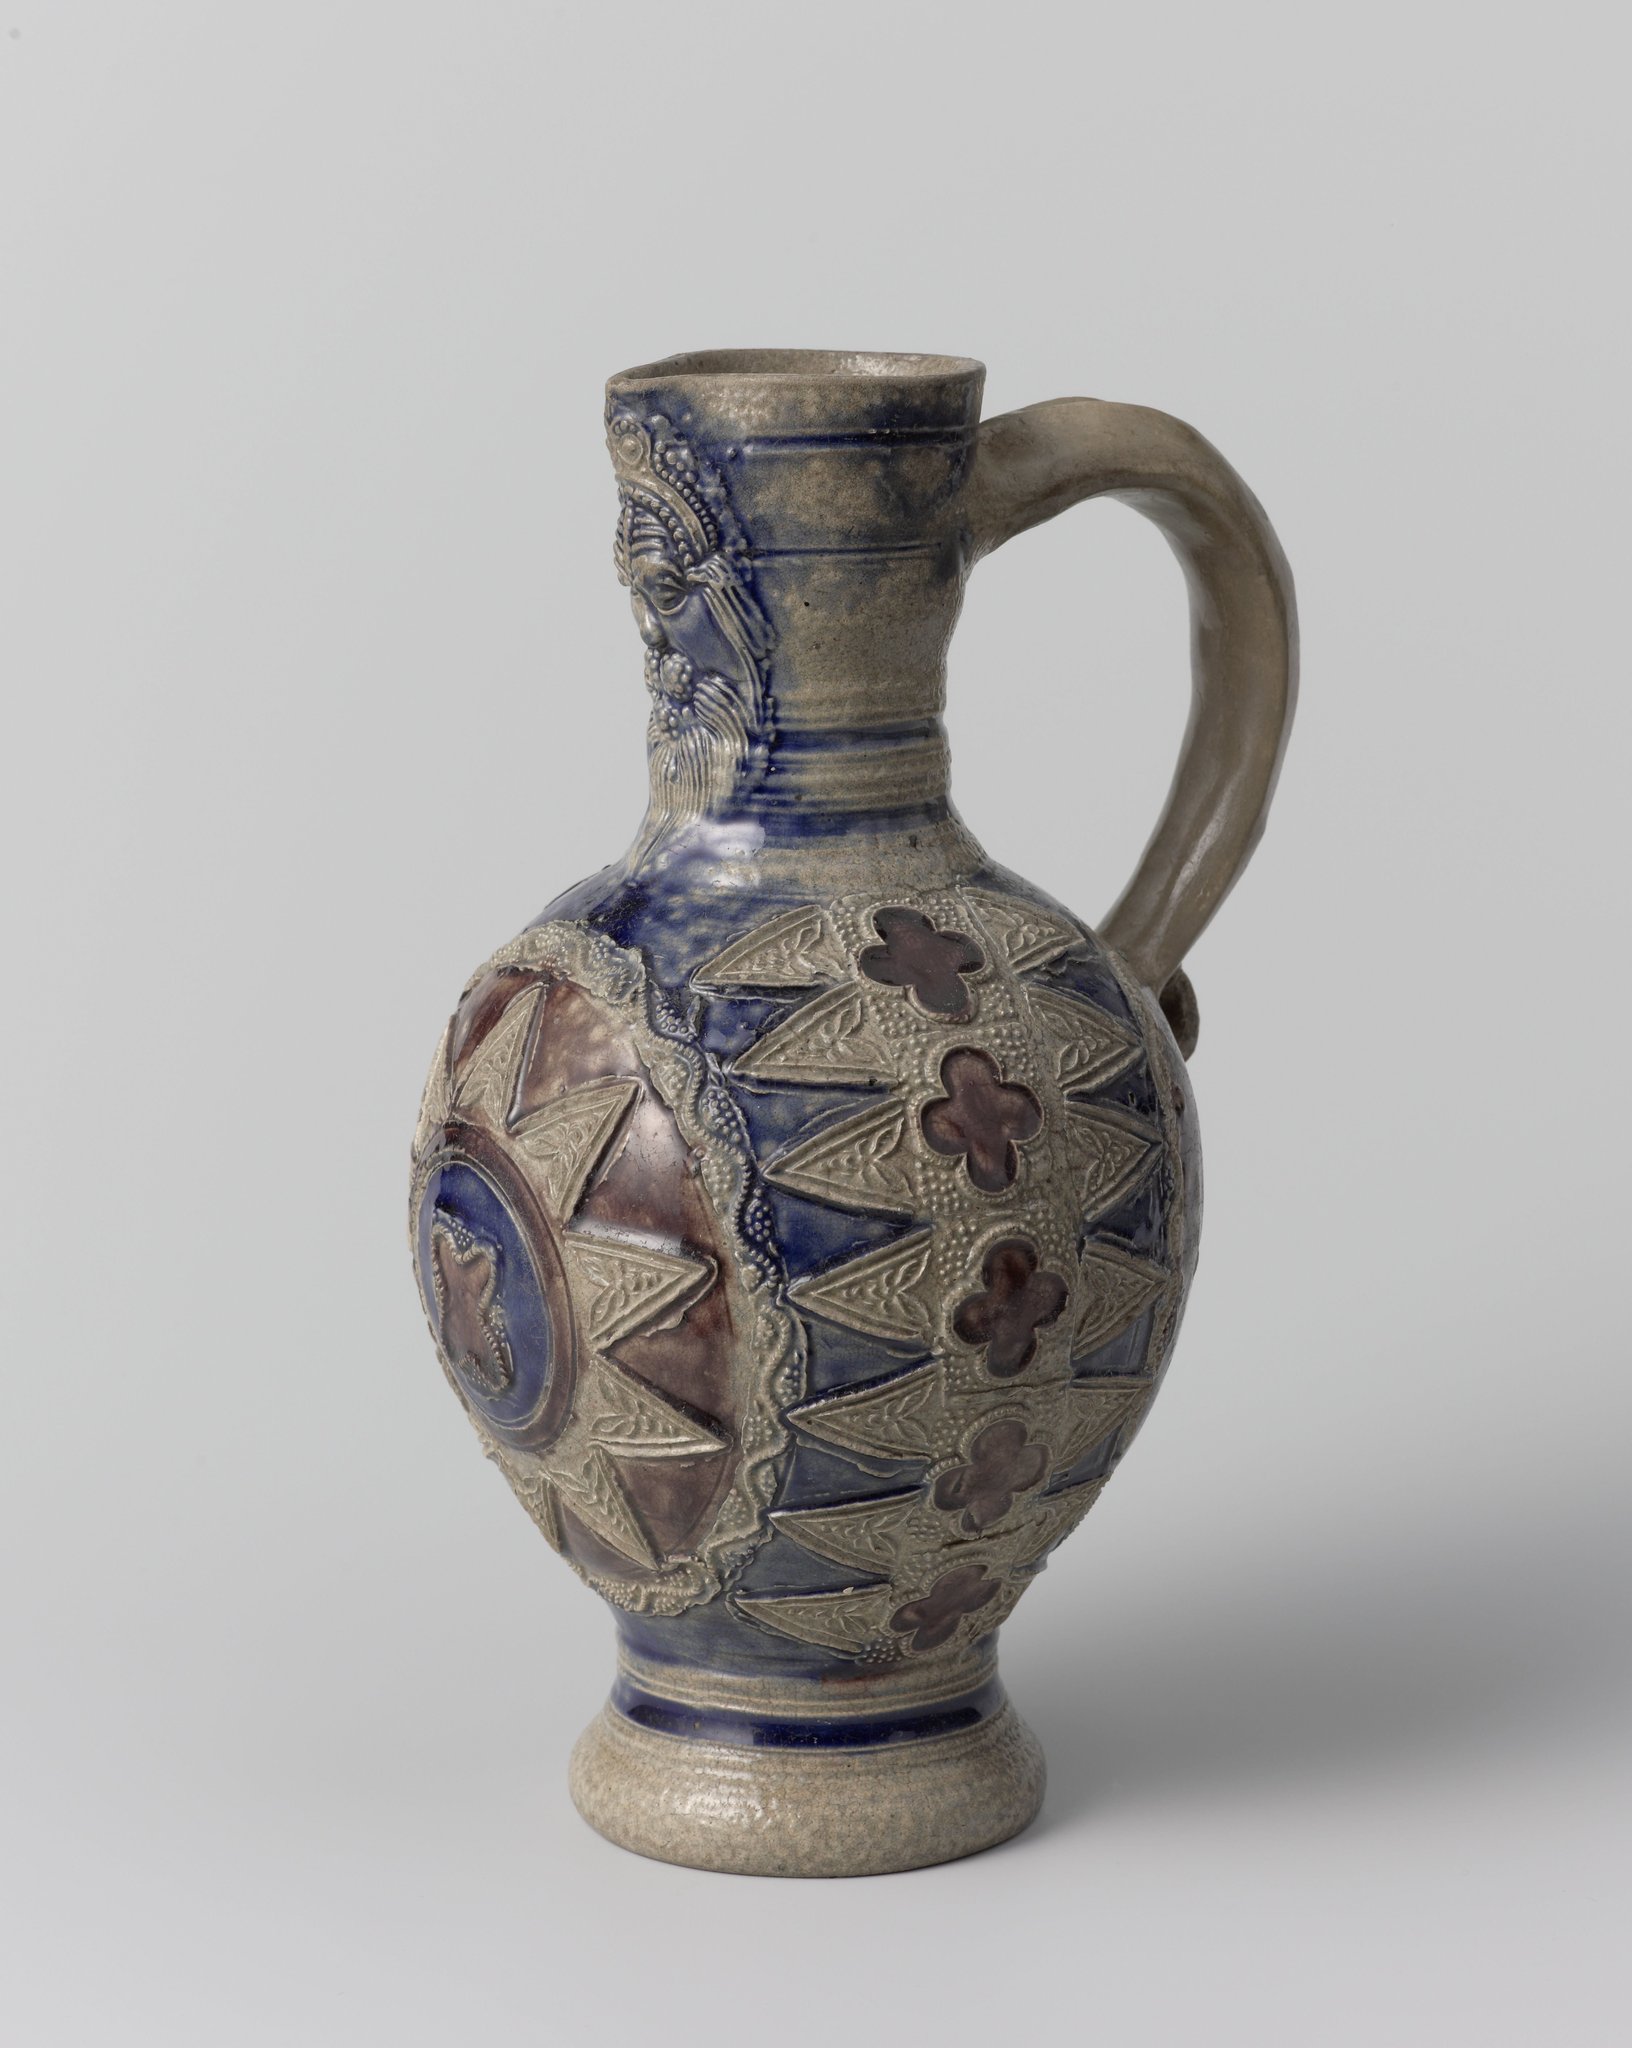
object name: ewer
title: Jug with a mask and stylized foliate ornamentation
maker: Anonymous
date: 1650-1674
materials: cobalt, glaze, mineral, stoneware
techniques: firing, forming, relief, turning, vitrification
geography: westerwald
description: Kan van steengoed op hoge voet met een eivormige buik en een smalle hals met geknepen tuit. Het C-vormige oor is bevestigd aan de nek en de schouder. Enkele ingegrifte lijnen op de voet en de nek. Gedeeltelijk bedekt met kobaltblauw en mangaanpaars. Op de nek een reliëfdecoratie met een gedrukt, opgelegd masker van een baardman of een leeuw. De voorzijde van de buik met concentrische cirkels van ranken en gestileerde, driehoekige bladmotieven. In het centrum een vierpas. Om het handvat een leeg medaillon. De zijkanten met een verticale lijn van vierpassen met aan weerszijden bladmotieven. Westerwald.